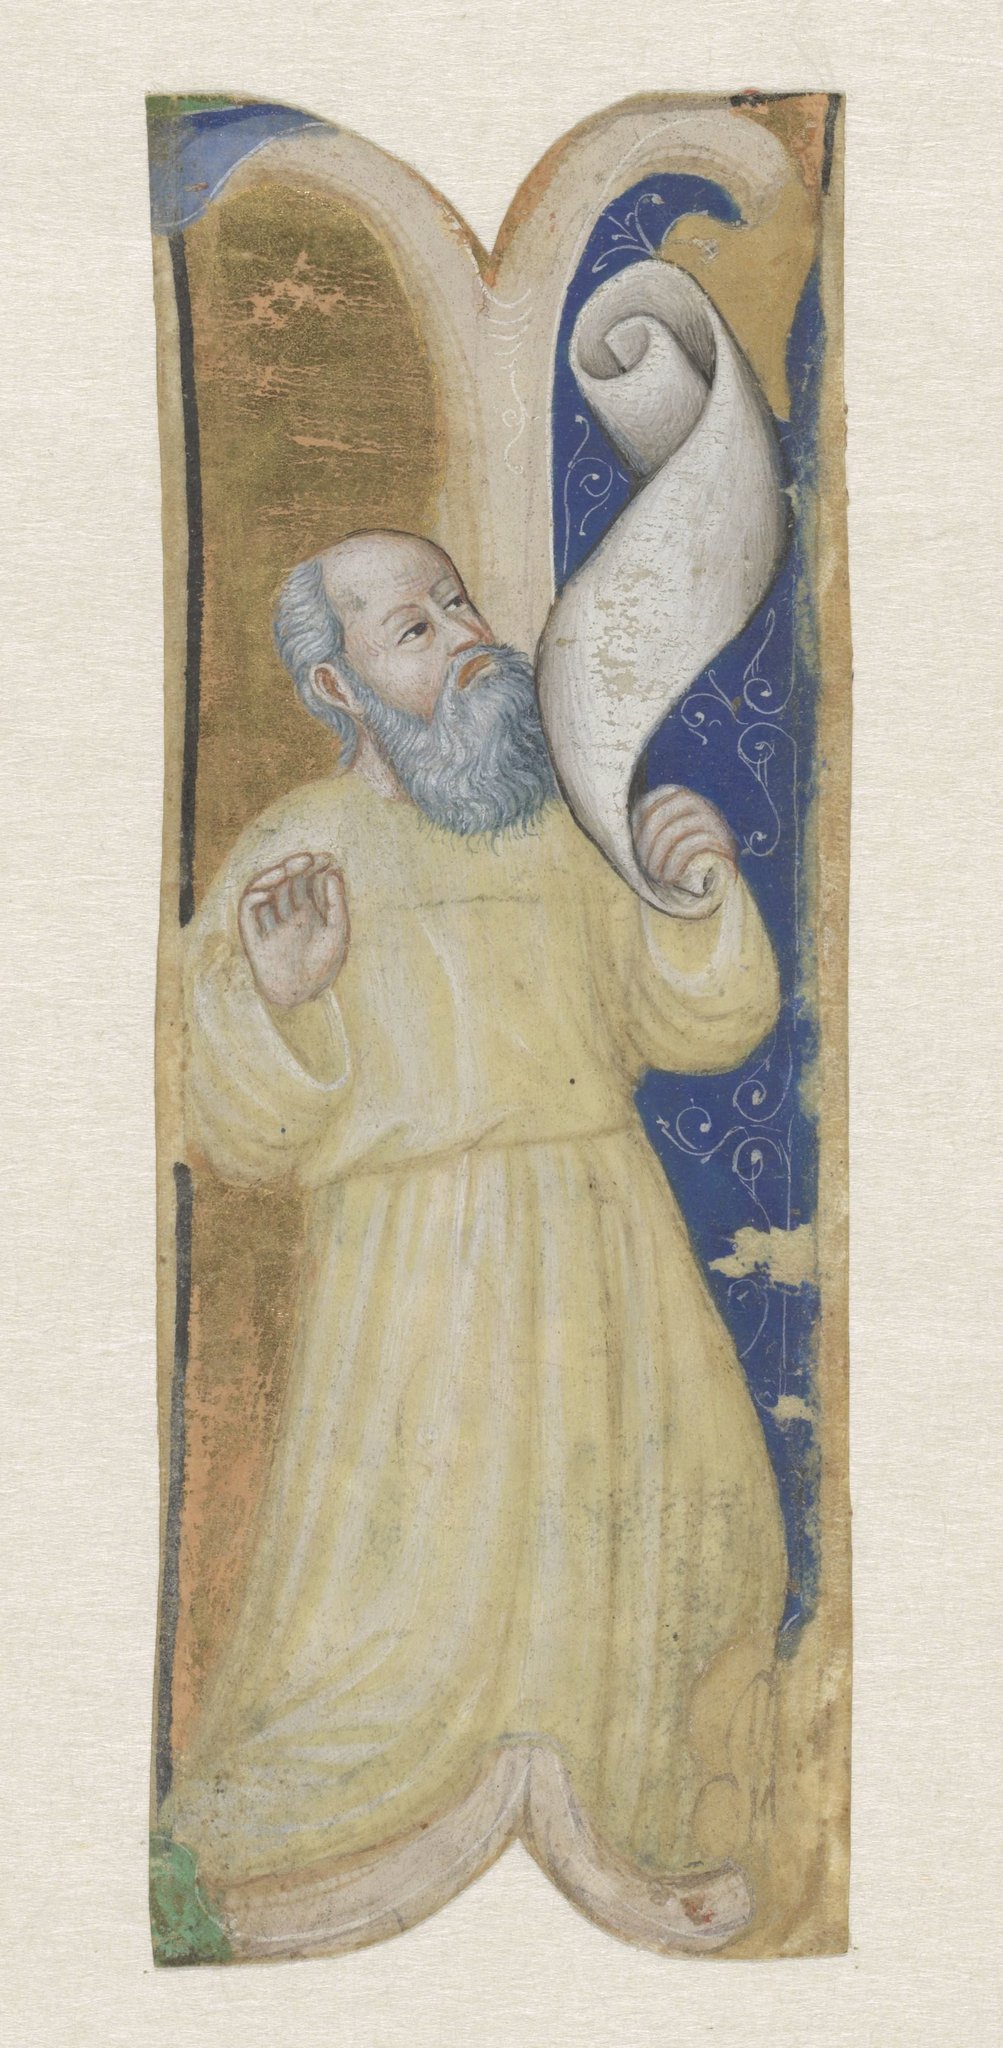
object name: miniature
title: Fragment van een koorboek: onbekende profeet of monnik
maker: Anonymous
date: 1375-1400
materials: paint, gold leaf, parchment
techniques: brush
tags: monk(s), friar(s)